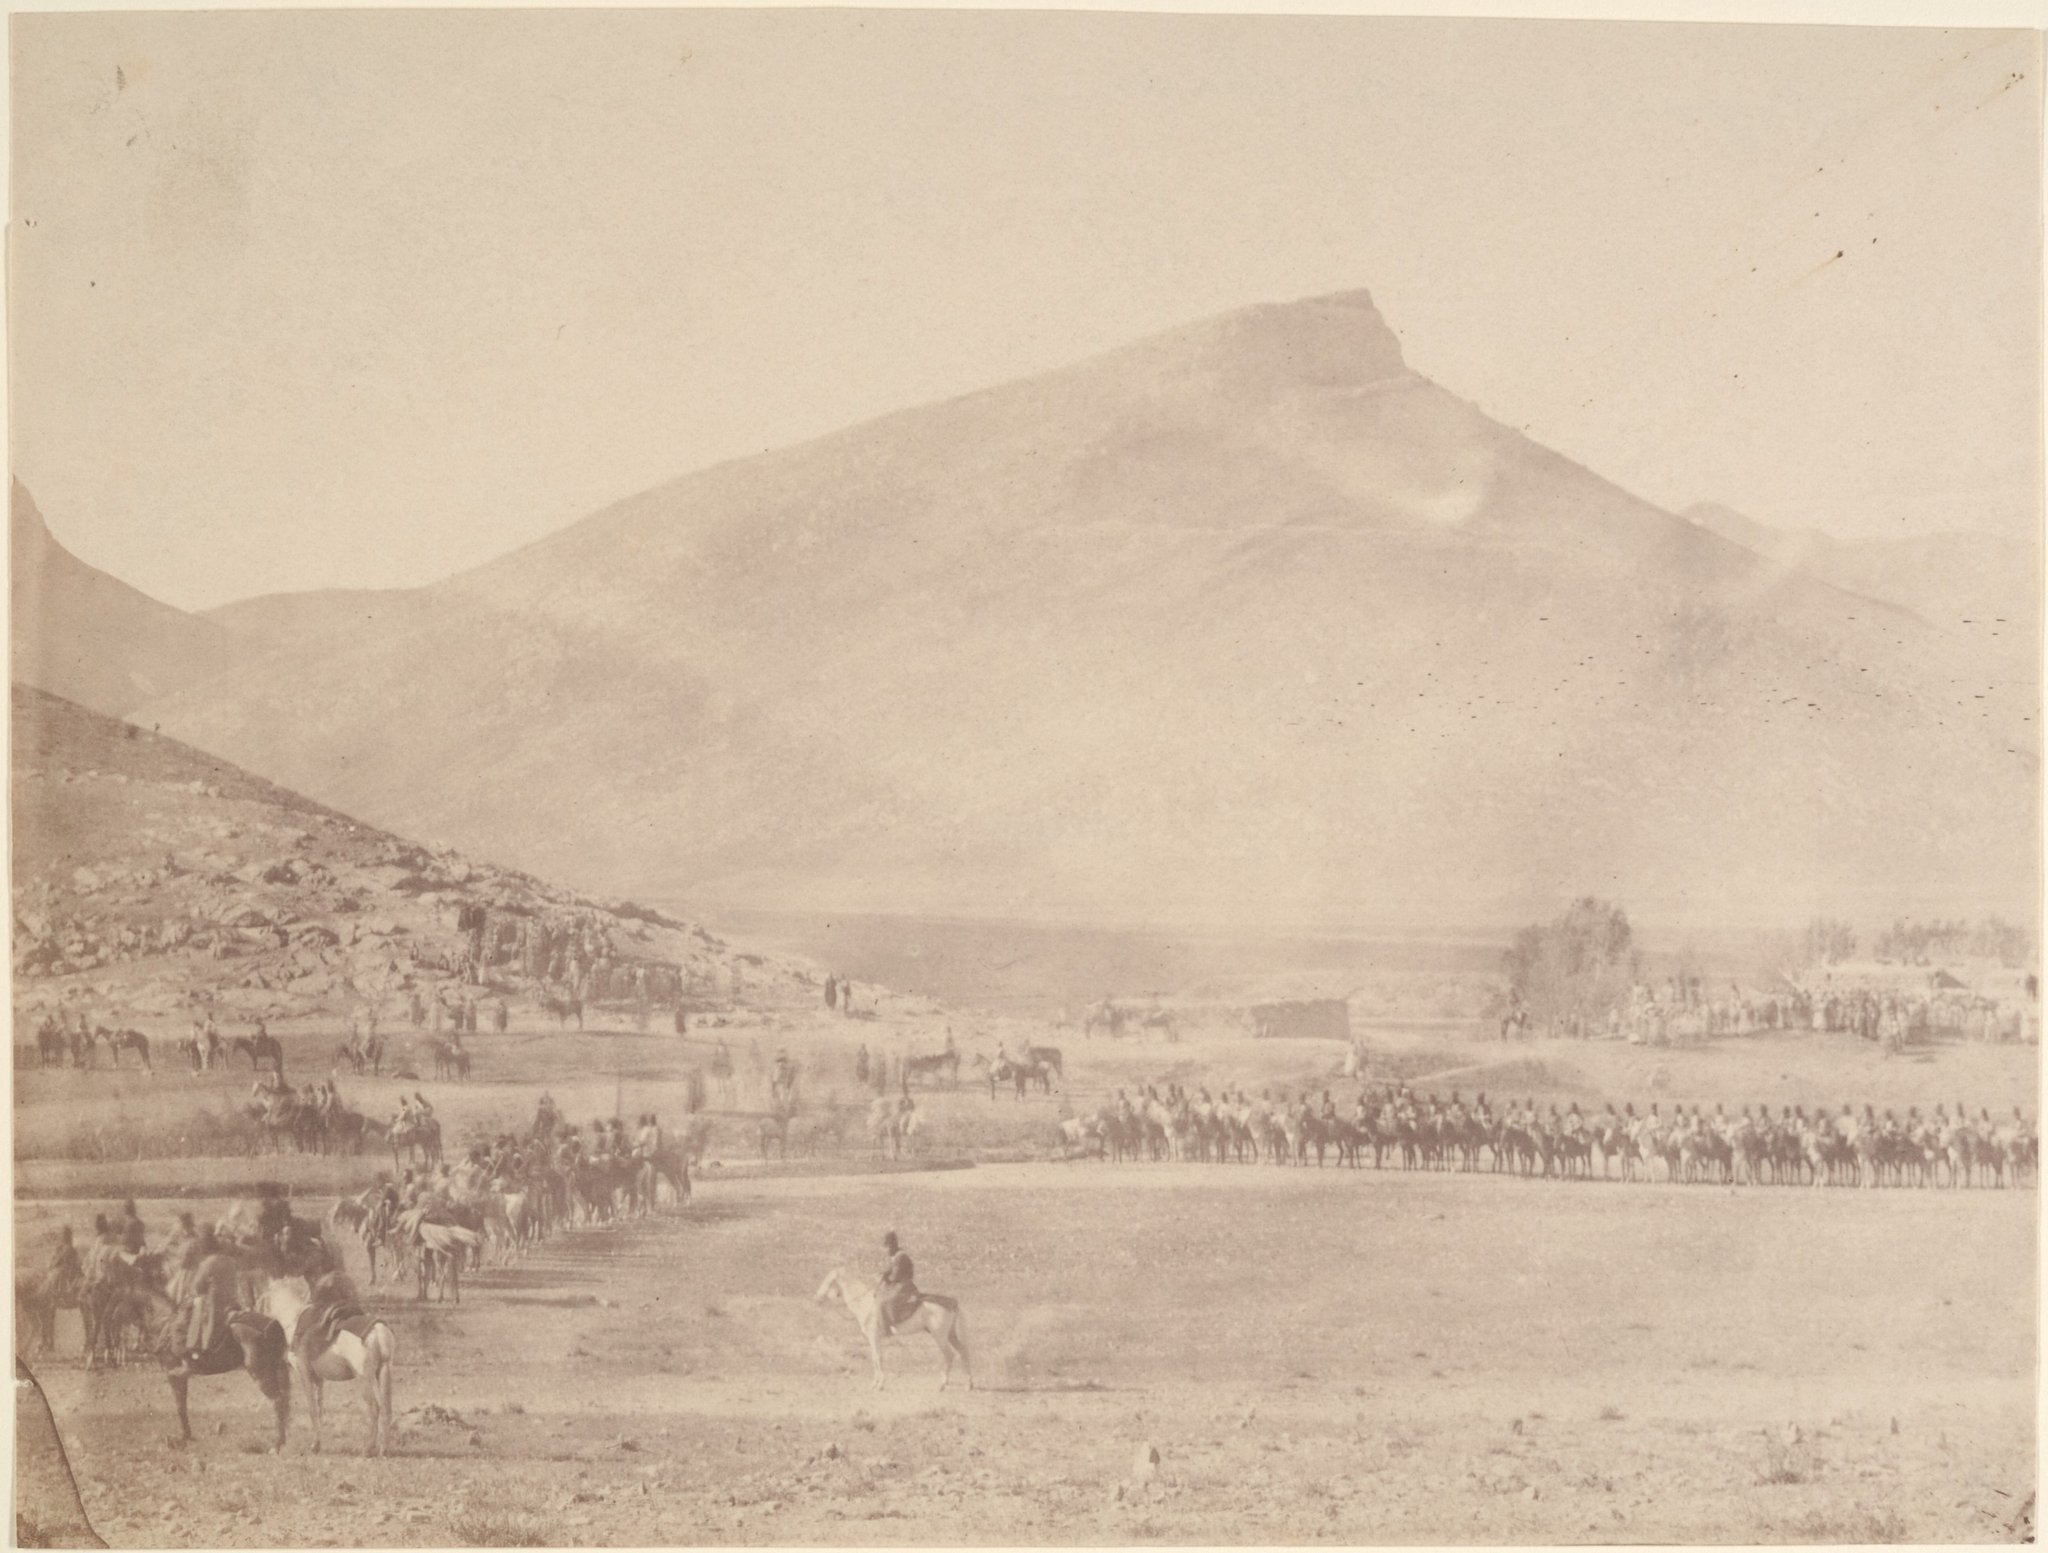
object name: photograph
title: [Departure for the huntTomb of Khan of Khiva]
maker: luigi pesce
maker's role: artist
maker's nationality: italian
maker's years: 1818-1891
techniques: salted paper print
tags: horses,mountains